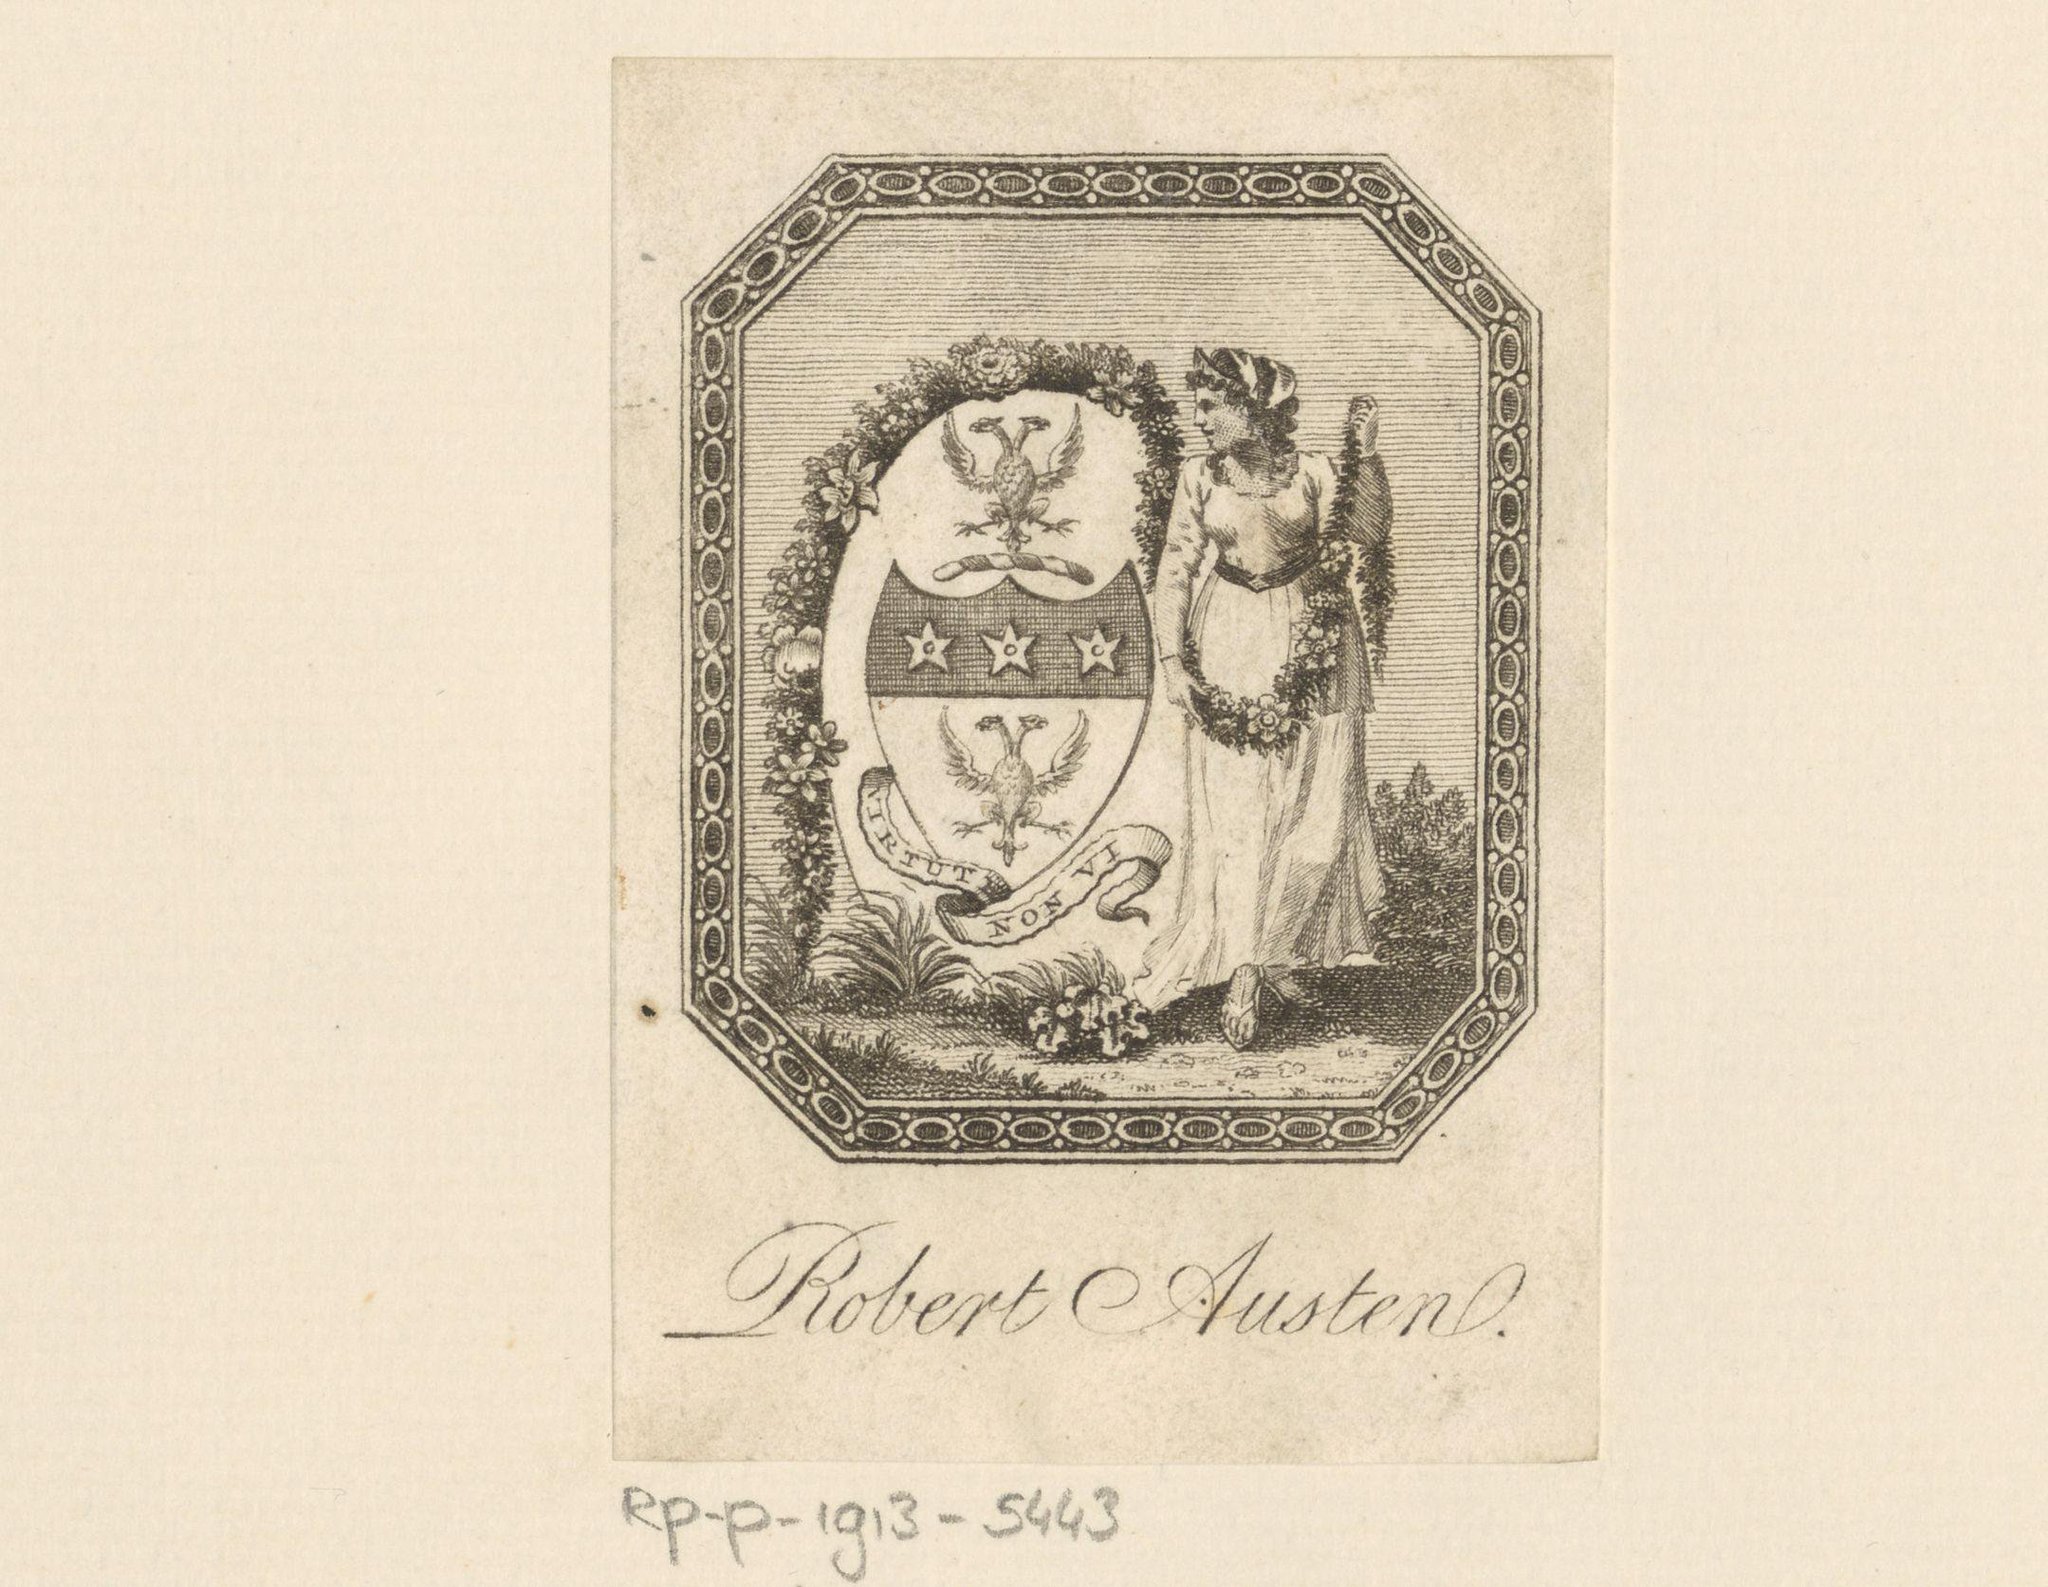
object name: bookplate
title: Ex libris van Robert Austen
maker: Anonymous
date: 1650-1749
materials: paper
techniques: etching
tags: armorial bearing, heraldry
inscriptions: collector's mark: Lugt 2760, collector's mark: Lugt 2233